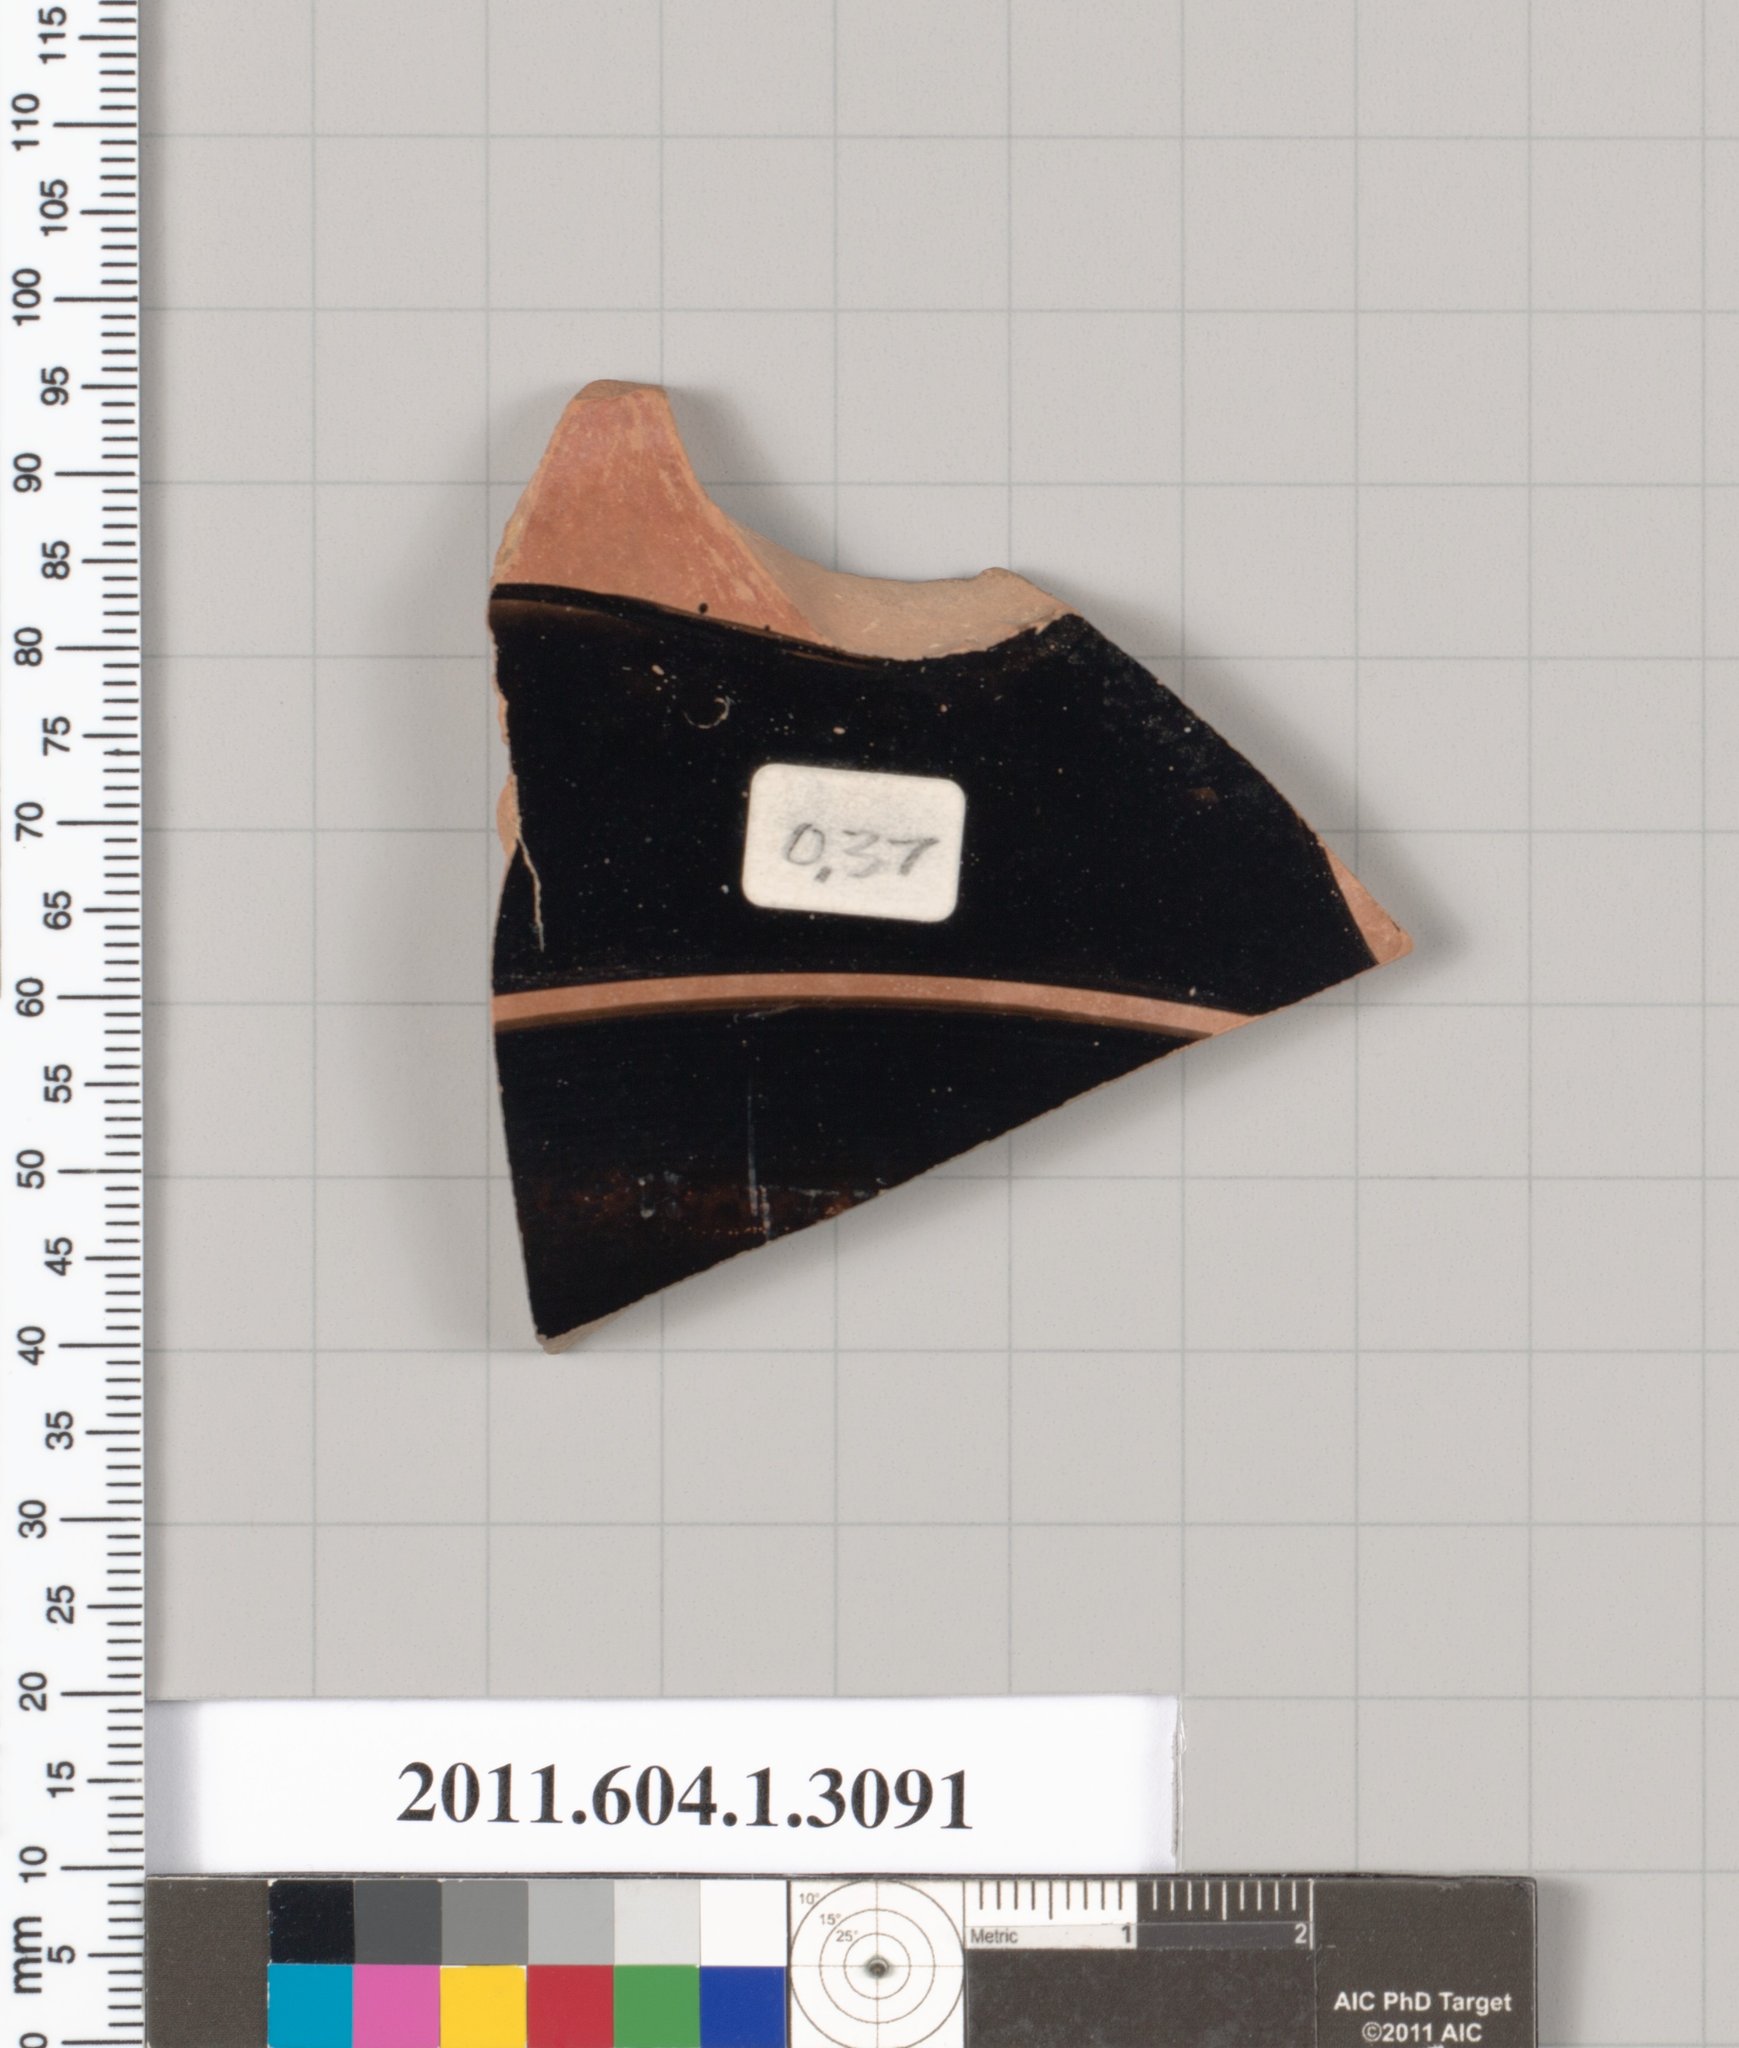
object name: kylix fragment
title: Terracotta fragment of a kylix (drinking cup)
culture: greek, attic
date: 600-401 BCE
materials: terracotta